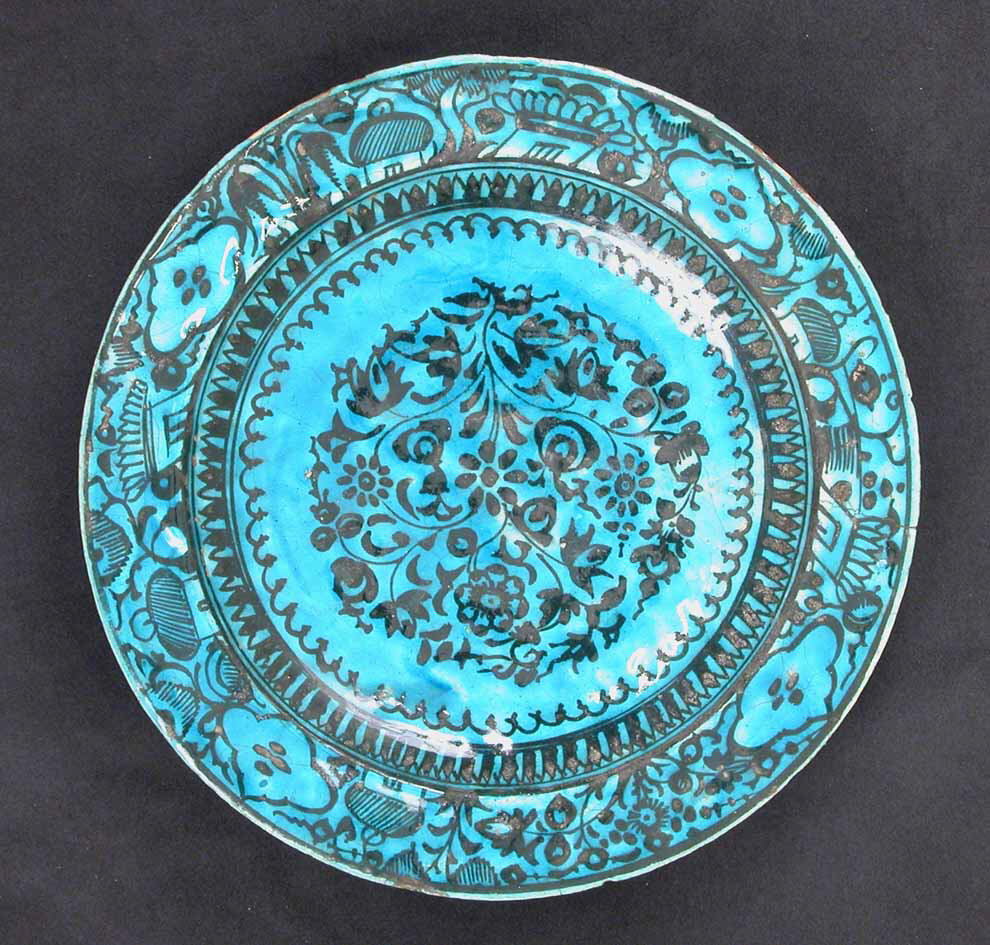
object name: dish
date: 1801-1900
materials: stonepaste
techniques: glazing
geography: iran